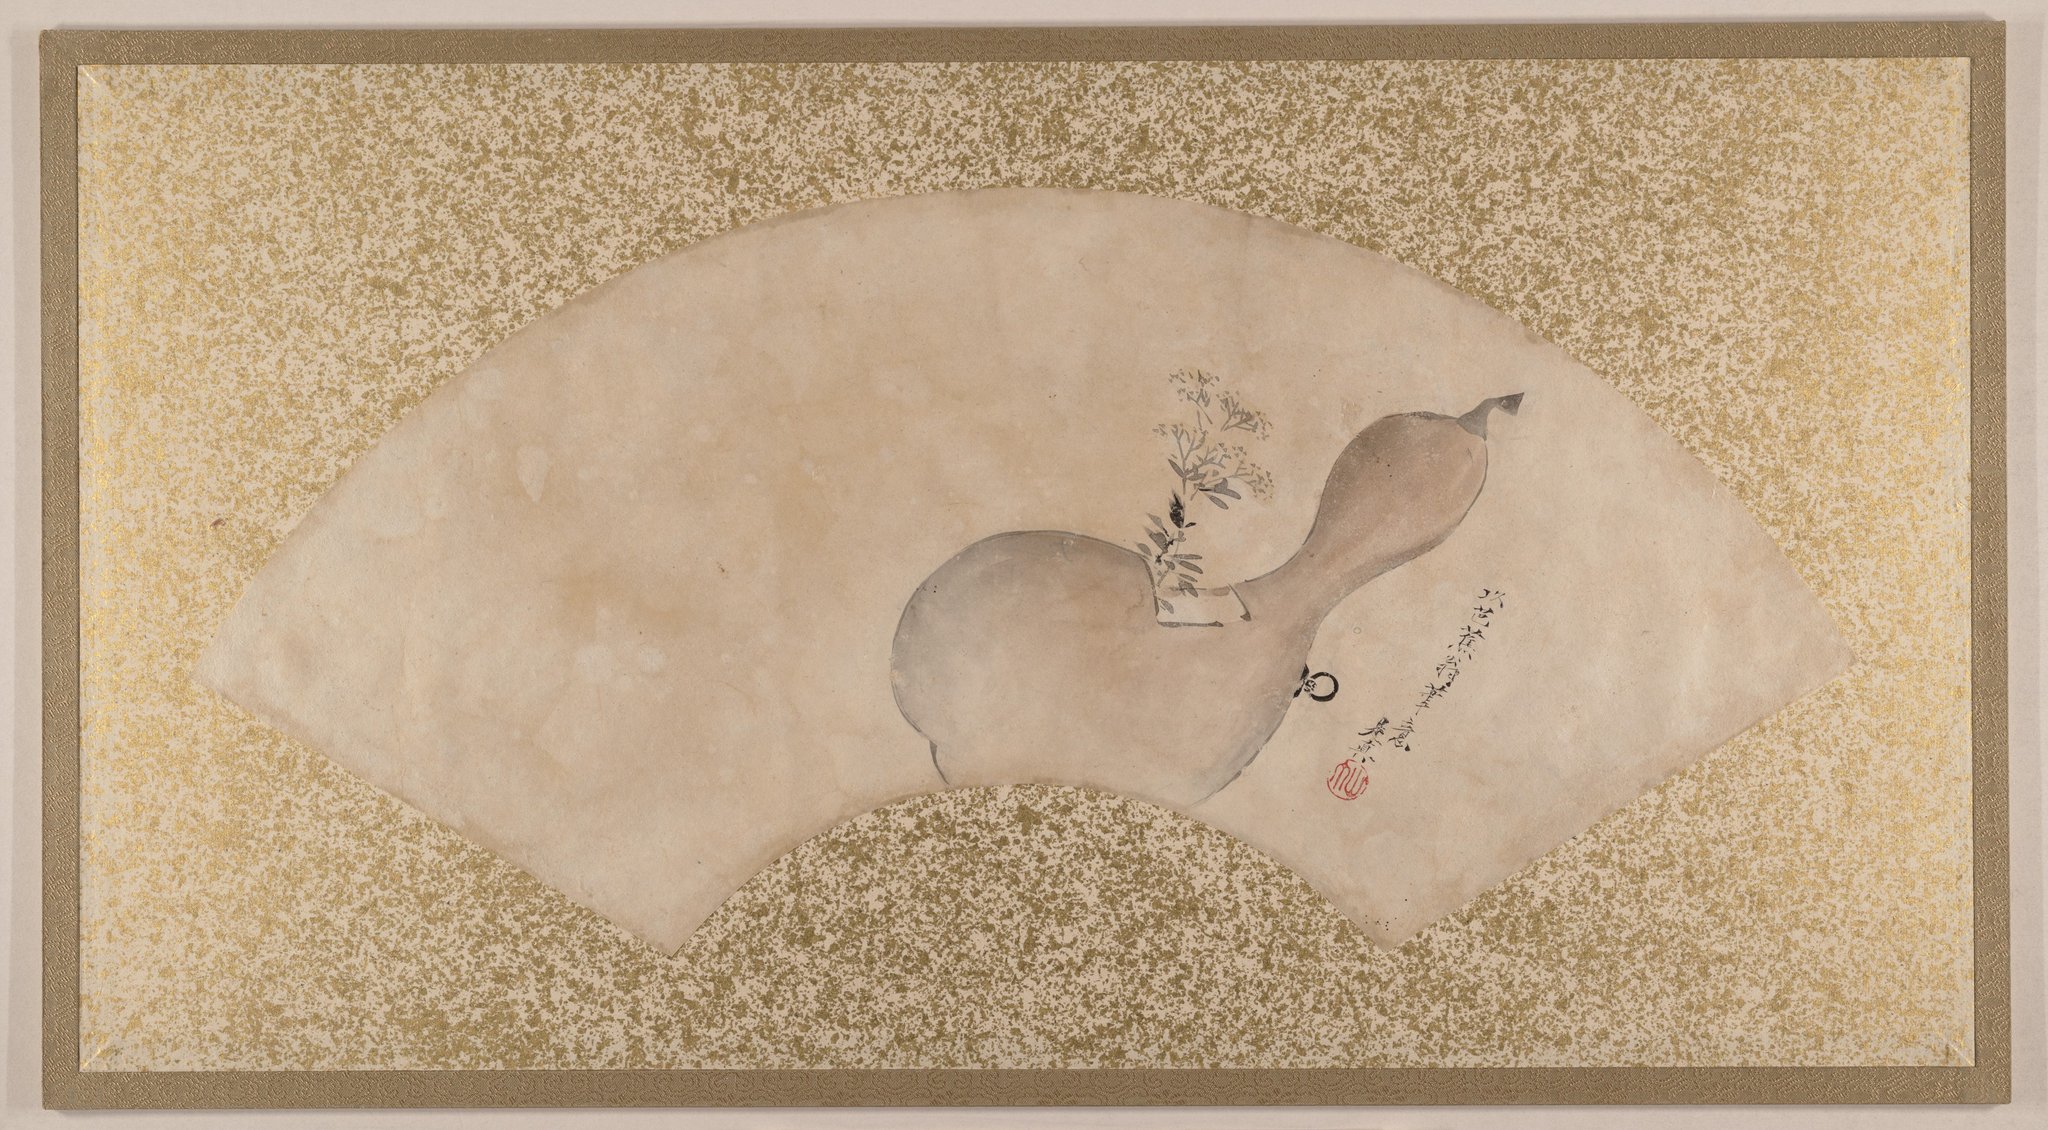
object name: album leaf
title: Flowers in Gourd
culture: japanese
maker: shibata zeshin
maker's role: artist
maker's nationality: japanese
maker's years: 1807-1891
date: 1867-1900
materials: paper, paint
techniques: painting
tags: gourds